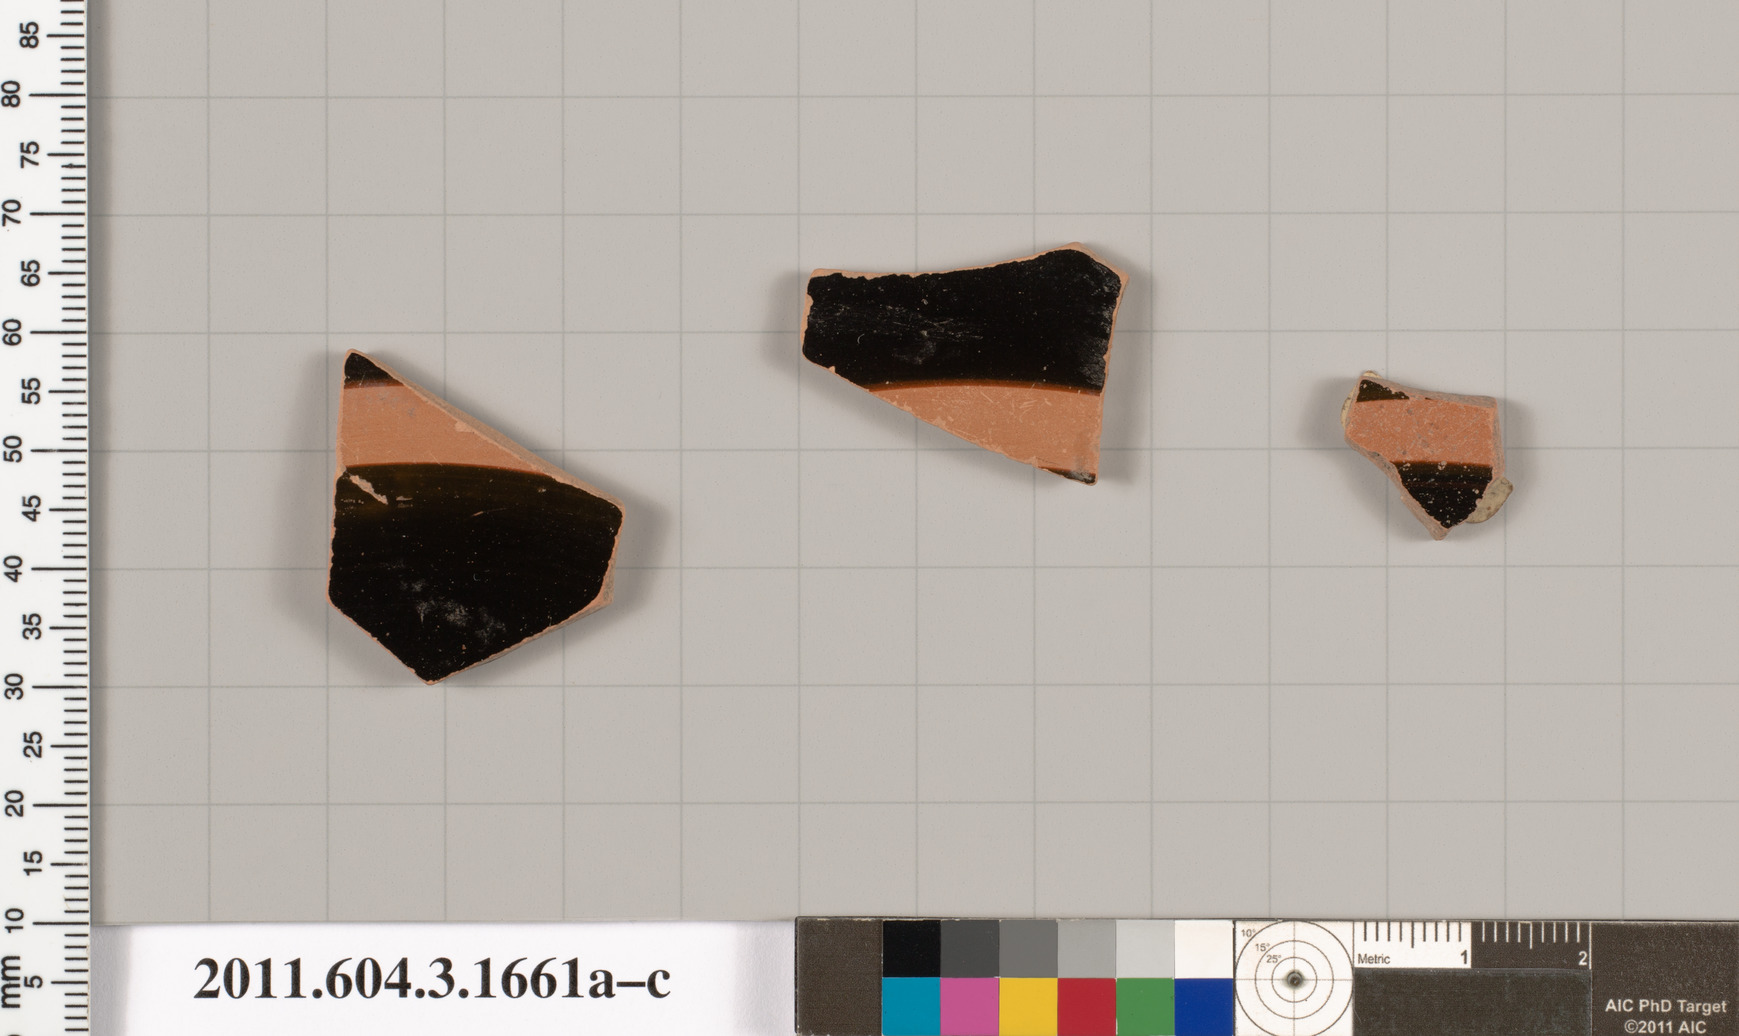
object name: kylix fragment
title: Terracotta fragments of kylikes: Band or lip cups (drinking cups)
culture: greek, attic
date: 550-526 BCE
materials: terracotta